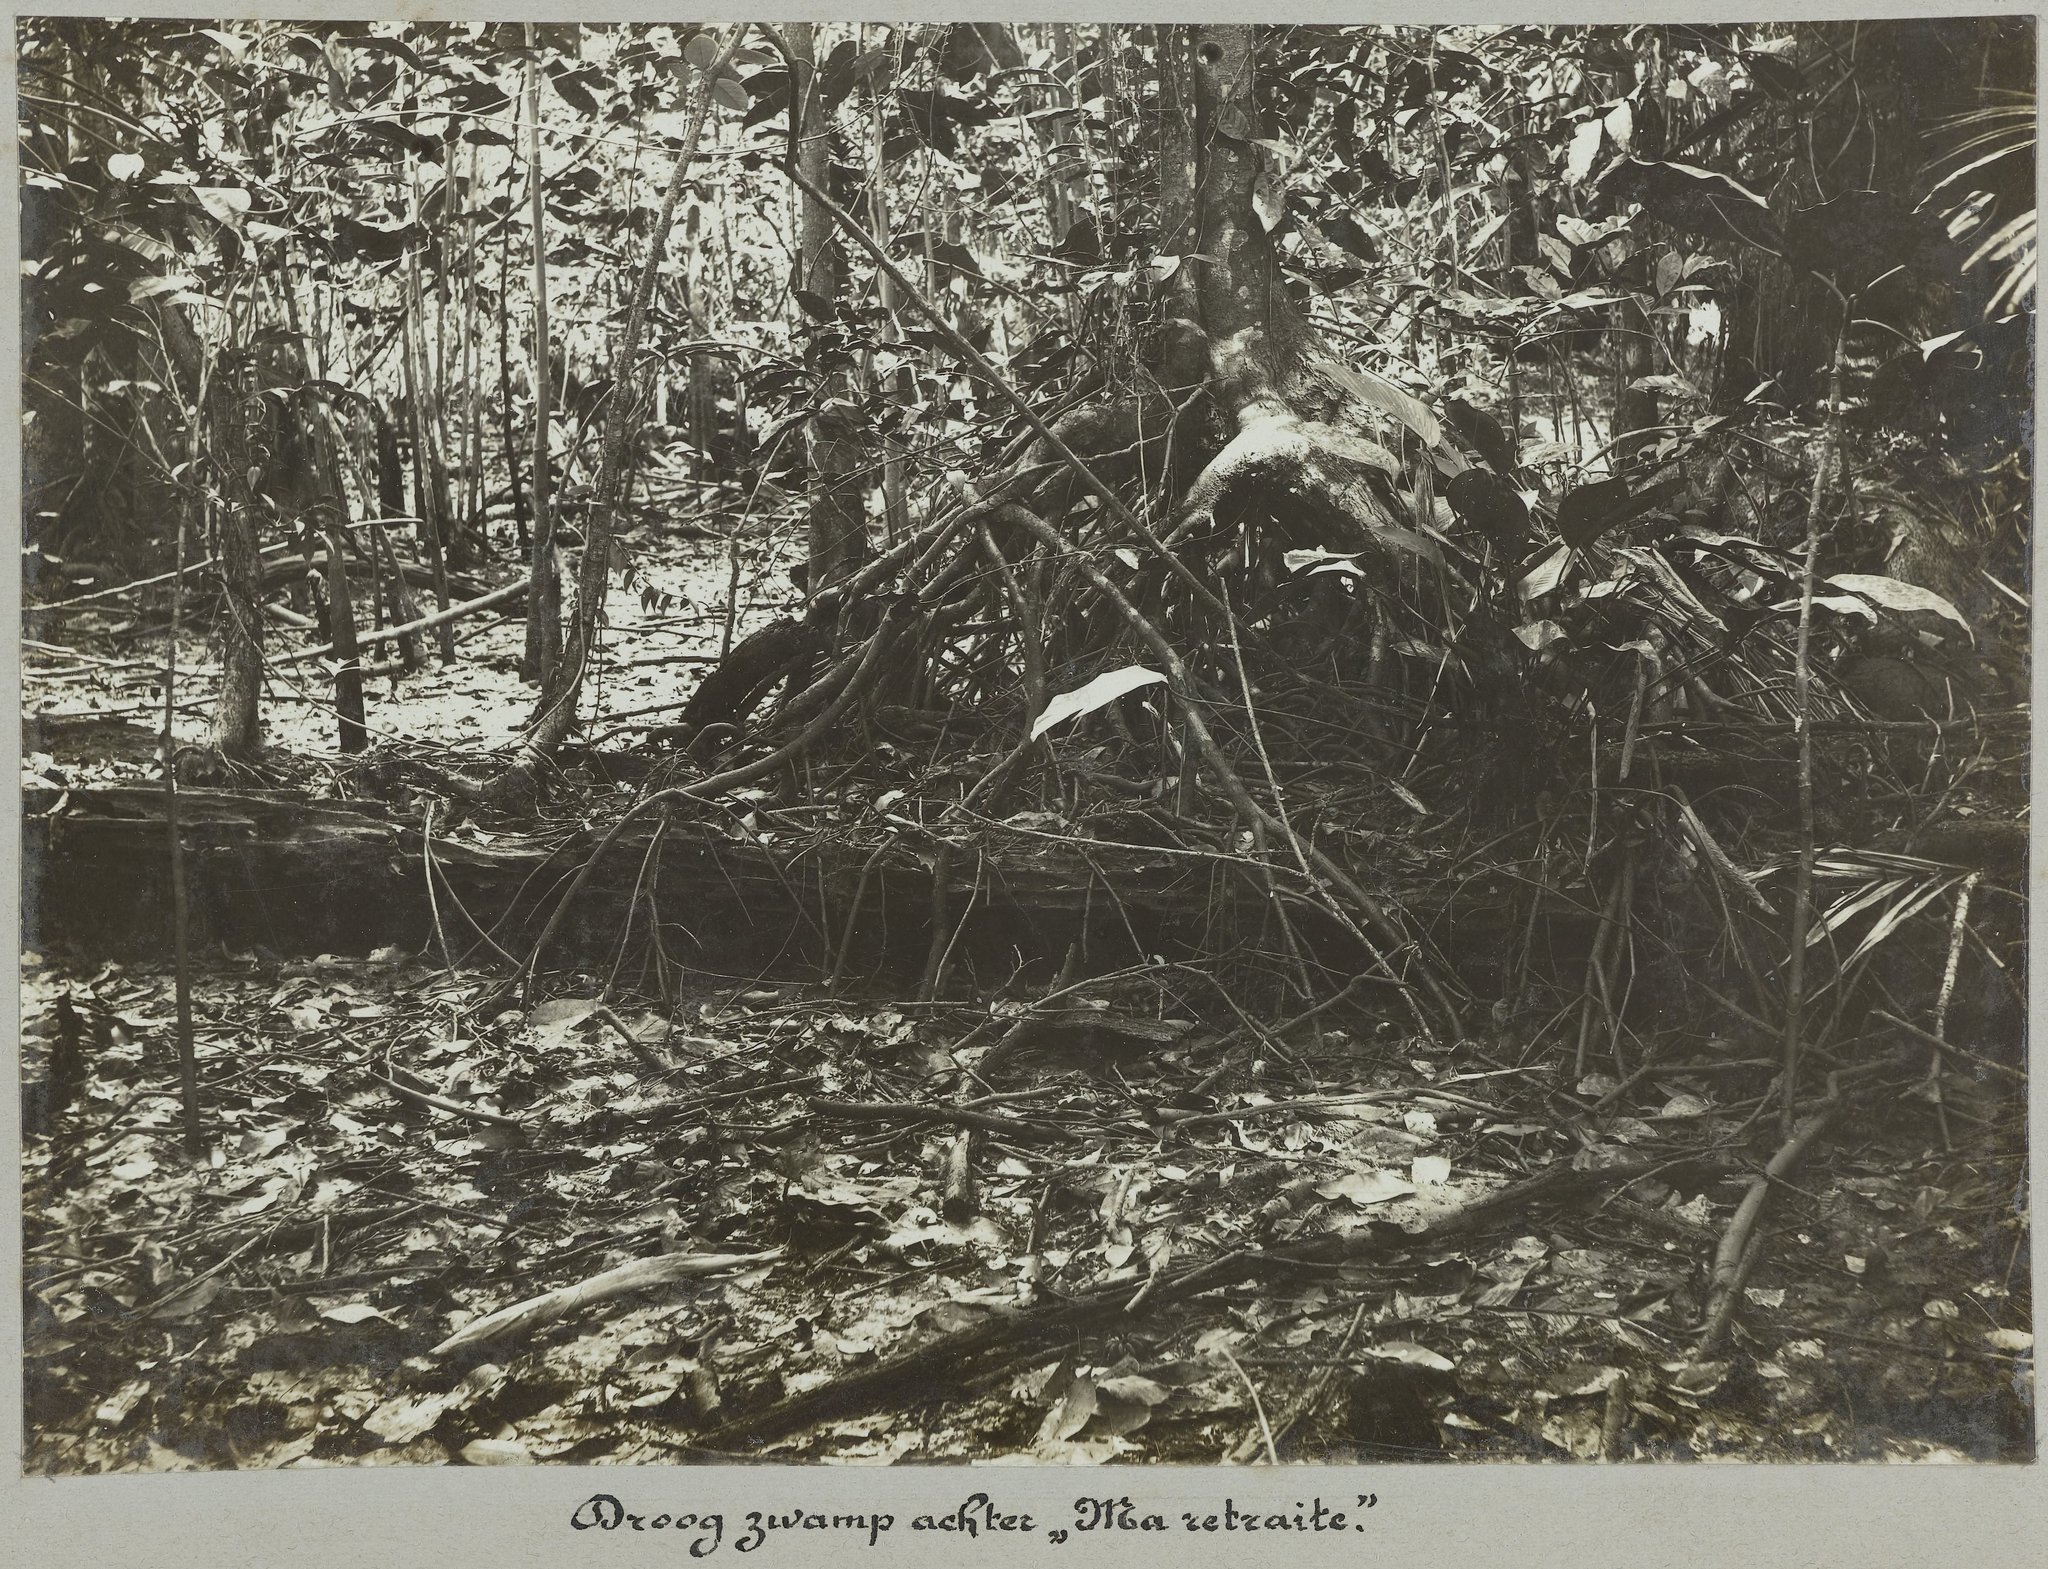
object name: photograph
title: Droog zwamp achter "Ma retraite"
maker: hendrik doijer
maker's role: engineer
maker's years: 1863-1925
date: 1903-1910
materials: photographic support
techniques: gelatin silver print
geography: suriname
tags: suriname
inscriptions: inscription: ‘A15 / Droog zwamp achter "Ma retraite".’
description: Droogevallen moeras op het terrein achter de plantage Ma Retraite. Onderdeel van het fotoalbum Souvenir de Voyage (deel 1), over het leven van de familie Doijer in en rond de plantage Ma Retraite in Suriname in de jaren 1903-1910.